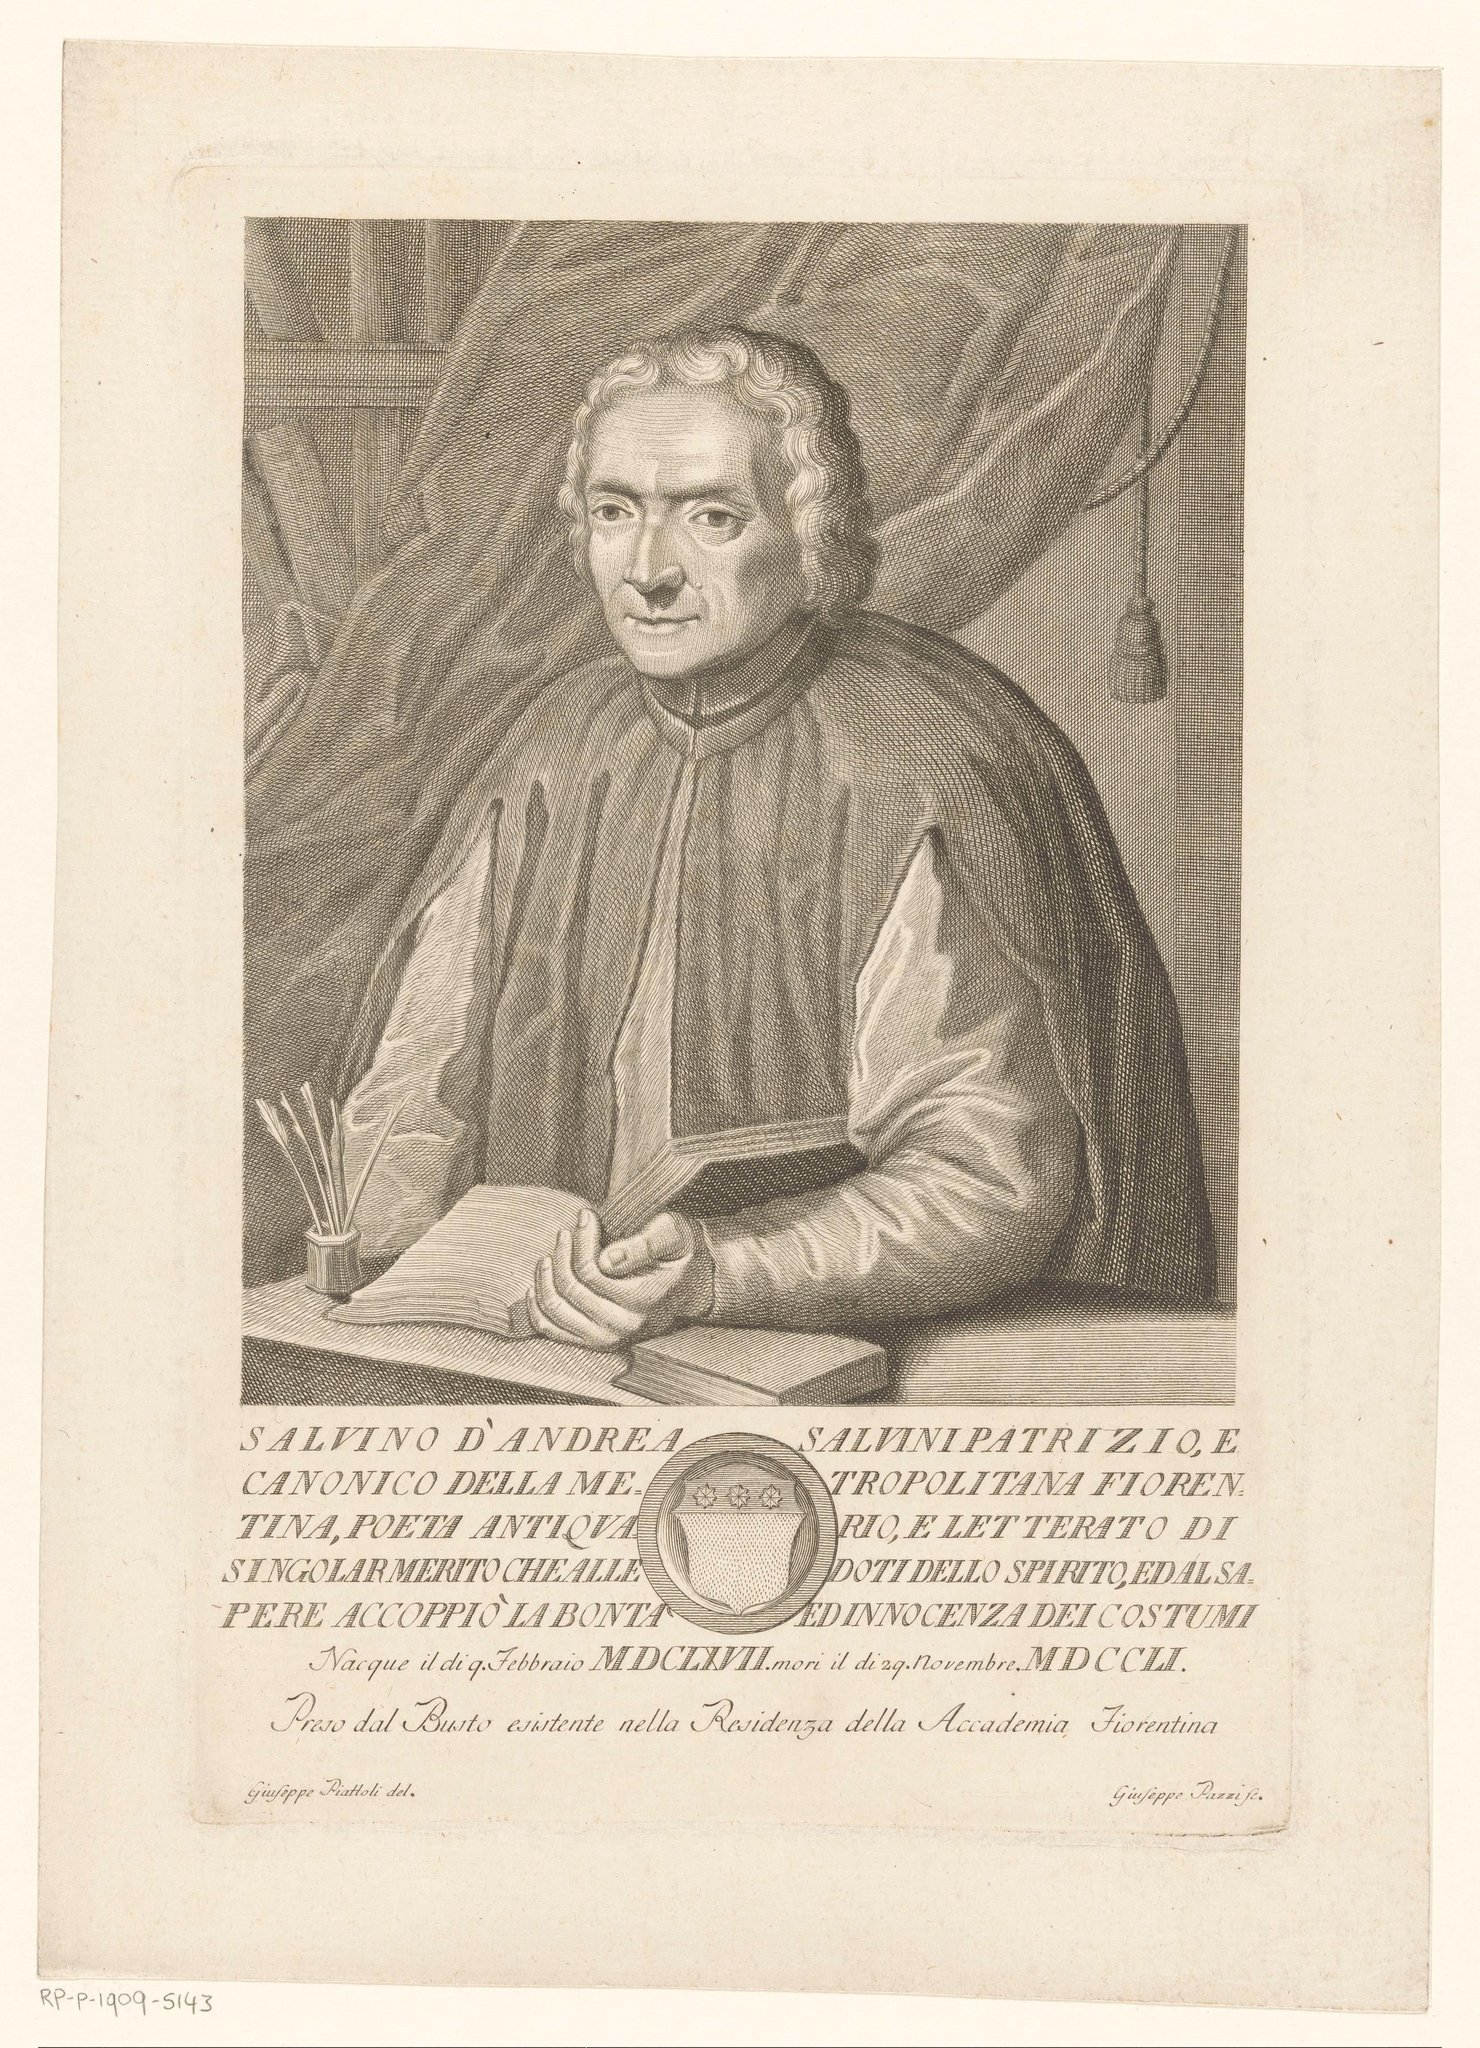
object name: print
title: Portret van dichter en humanist Salvino Salvini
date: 1843-1882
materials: paper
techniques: engraving, etching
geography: florence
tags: historical persons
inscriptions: collector's mark: Lugt 2228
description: In de ondermarge een wapenschild en een tekst in het Latijn.